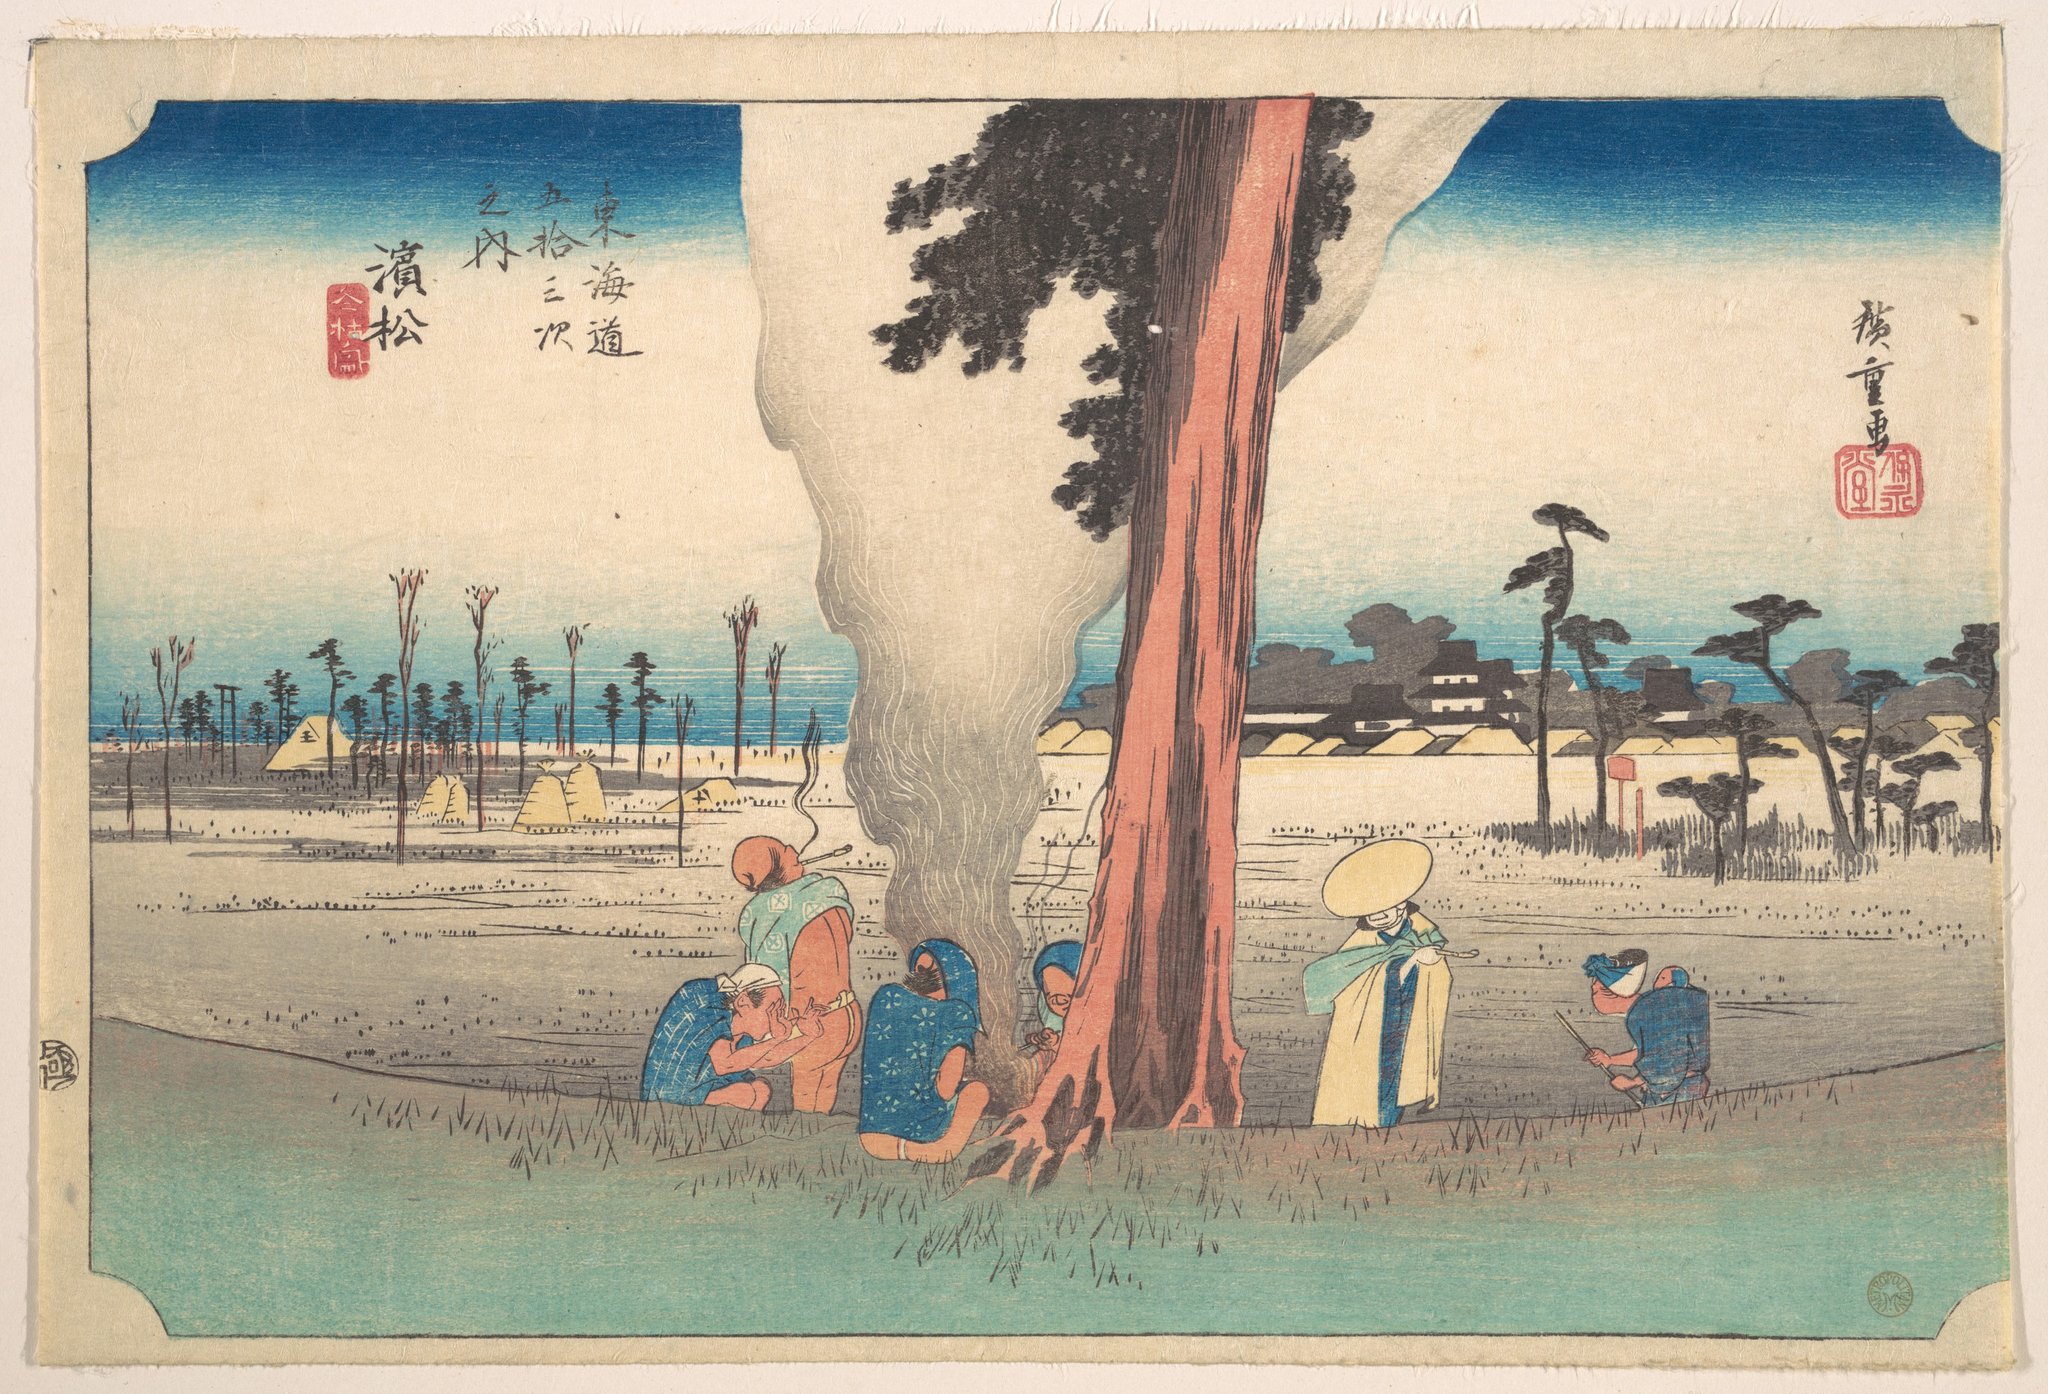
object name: print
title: Hamamatsu, Toko no Zu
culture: japanese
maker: utagawa hiroshige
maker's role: artist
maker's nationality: japanese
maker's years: 1797-1858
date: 1834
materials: ink, paper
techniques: woodblock print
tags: human figures,smoking,trees